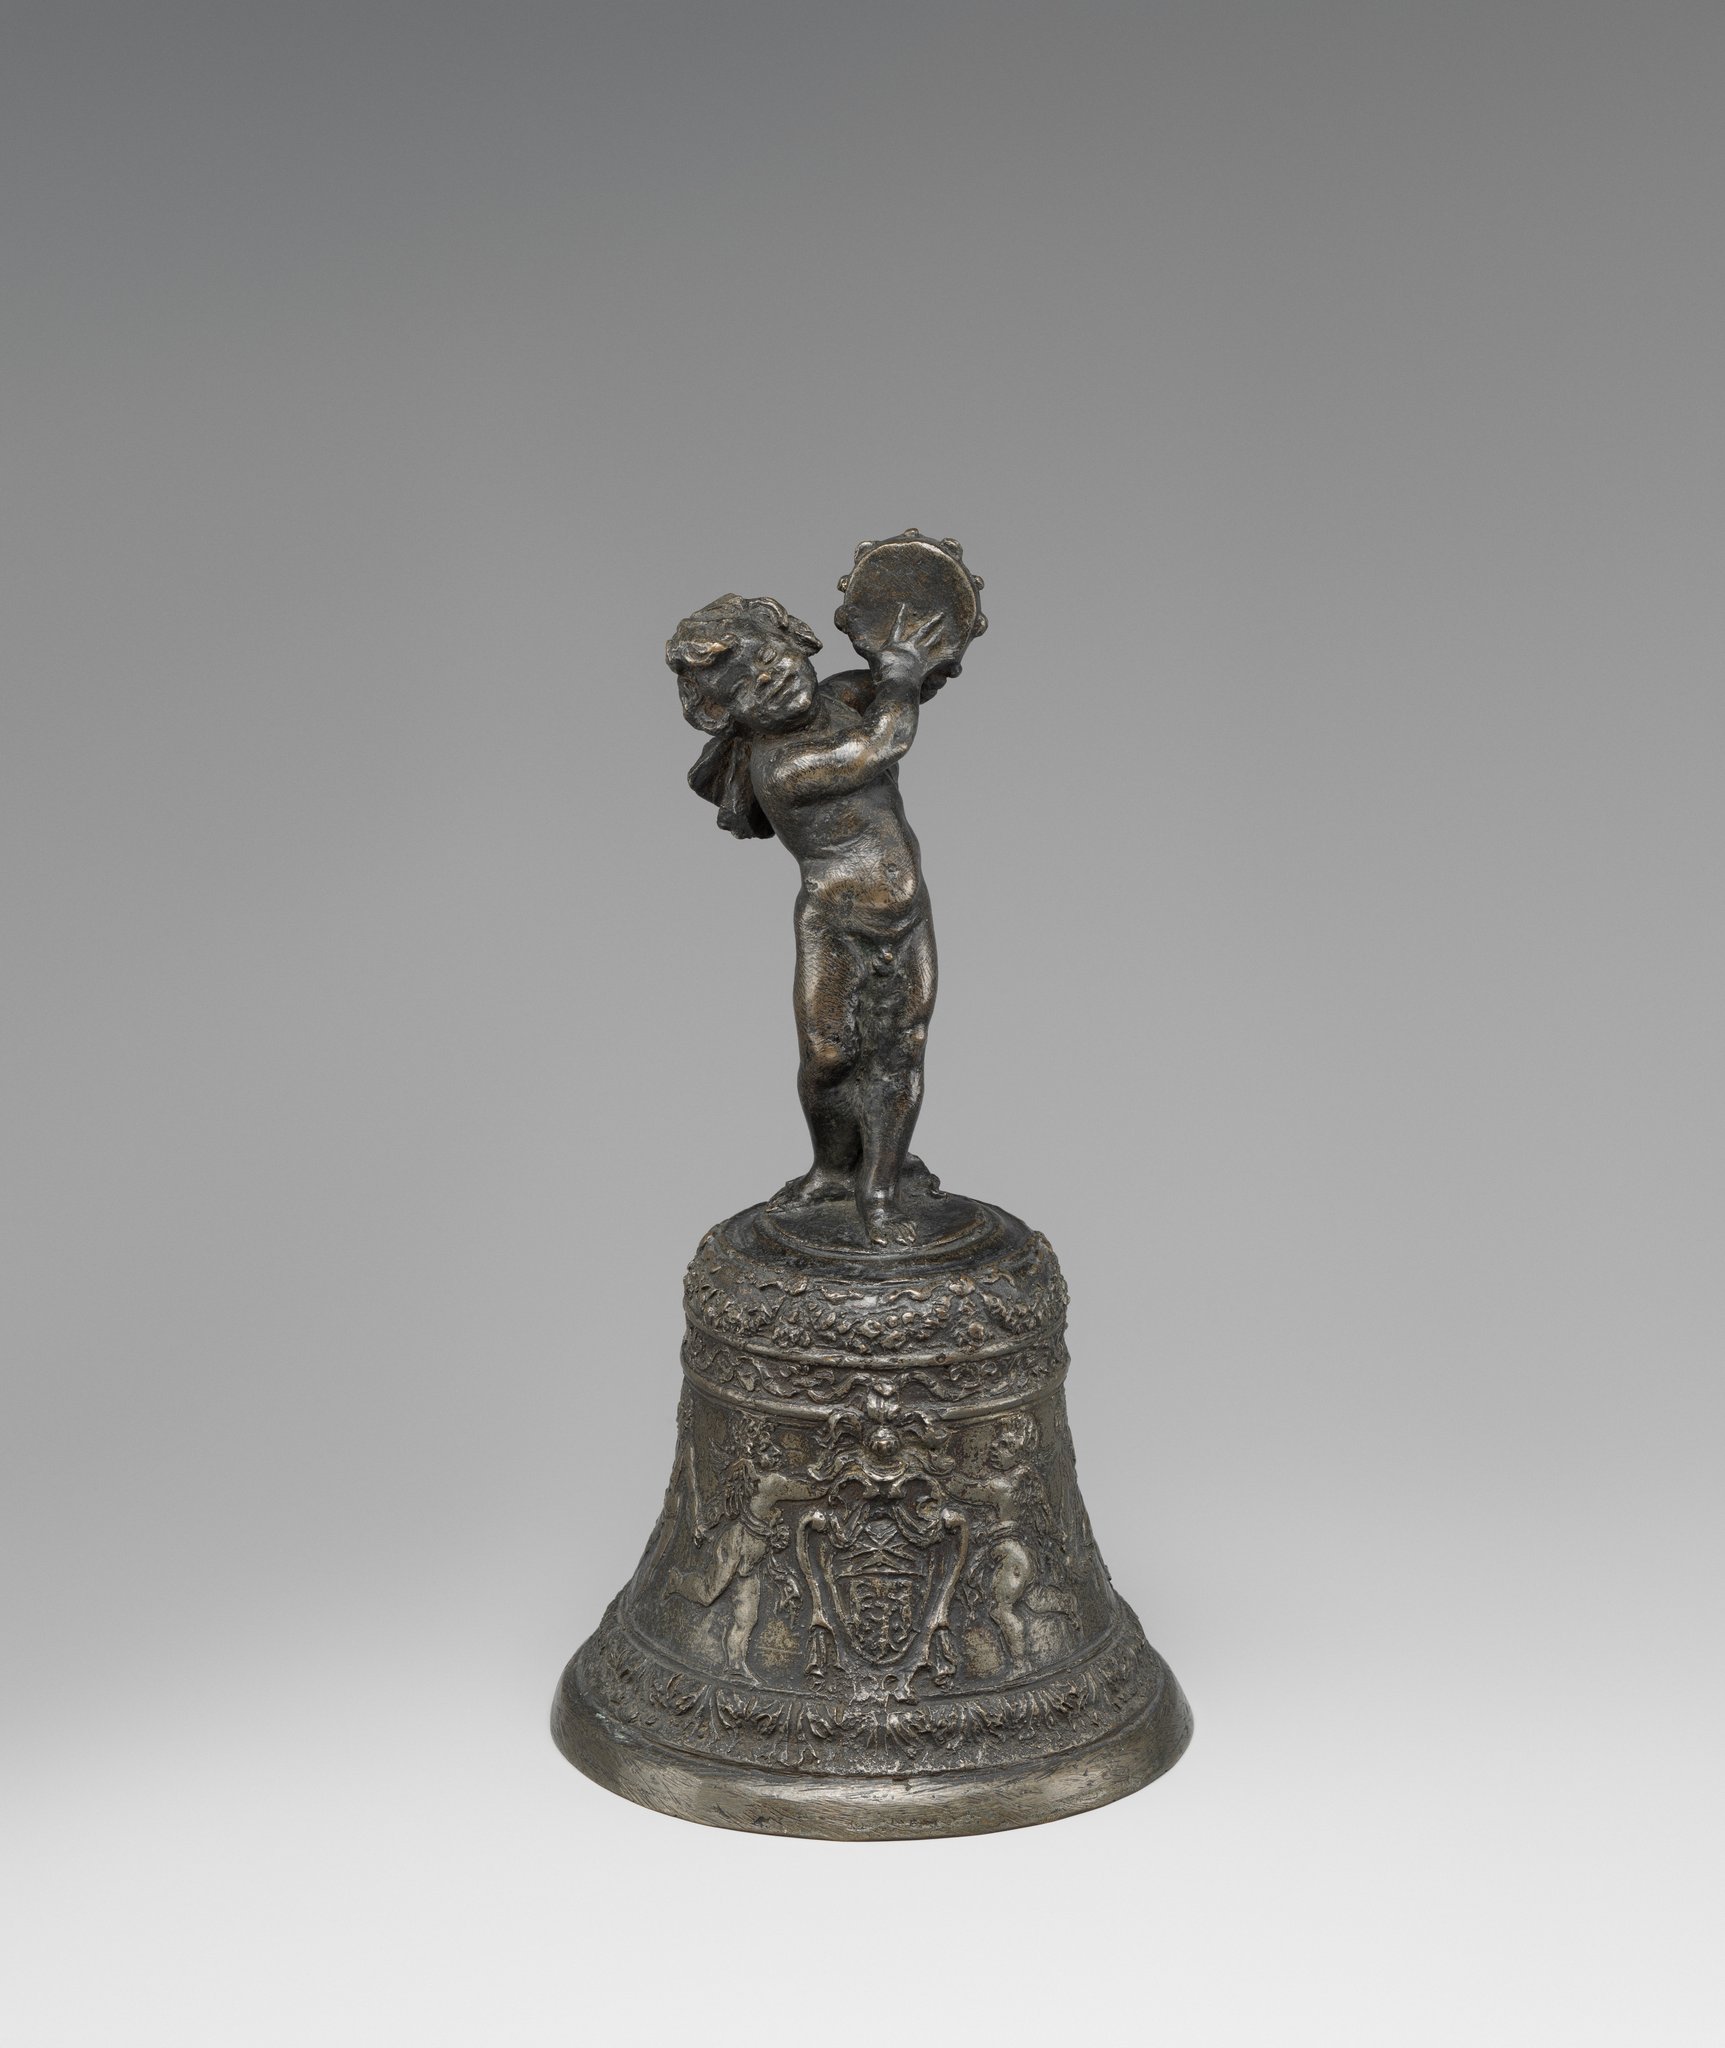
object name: bell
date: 1501-1600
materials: bronze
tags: putti,coat of arms